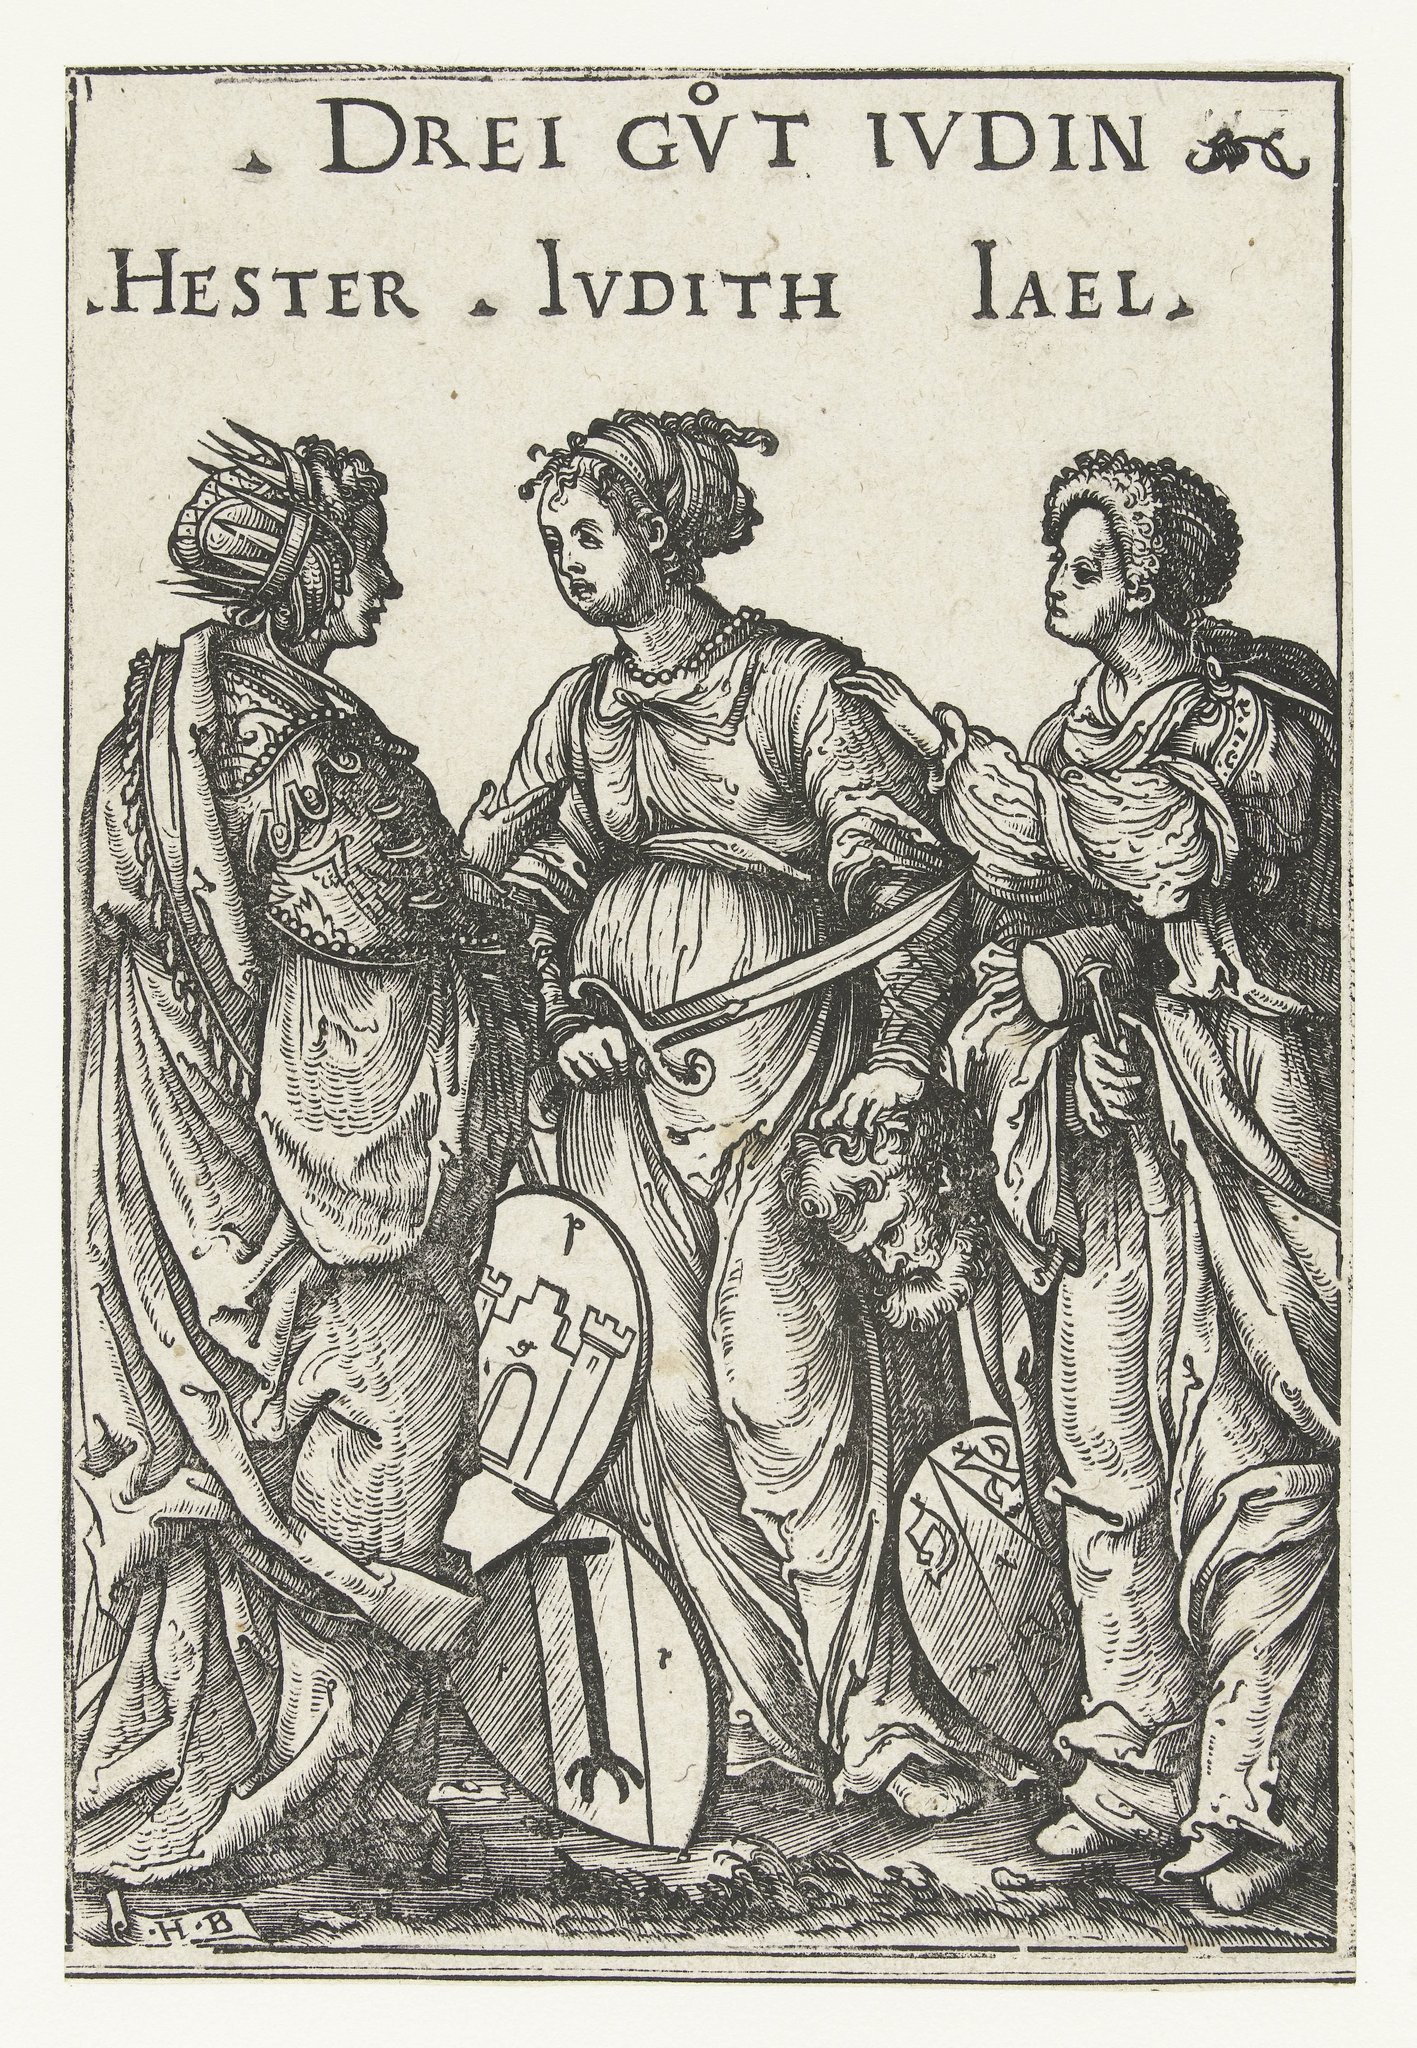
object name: print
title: Drei güt Ivdin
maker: hans burgkmair (i)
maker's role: draughtsman, print maker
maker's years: 1473-1531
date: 1516-1519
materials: paper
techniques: woodcut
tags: jael (one of the nine worthiest women), judith (one of the nine worthiest women), esther (one of the nine worthiest women)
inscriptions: collector's mark: Lugt 240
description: Ester staat links in haar mooiste kleren en zij draagt een kroon op haar hoofd. In het midden staat Judit met in haar handen een zwaard en het hoofd van Holofernes. Rechts staat Jaël met een hamer en een nagel in haar hand, zij legt haar andere hand op de schouder van Judit. Op de grond staan drie schilden met de wapens van de vrouwen. De Duitse tekst identificeert hen als drie joodse heldinnen.